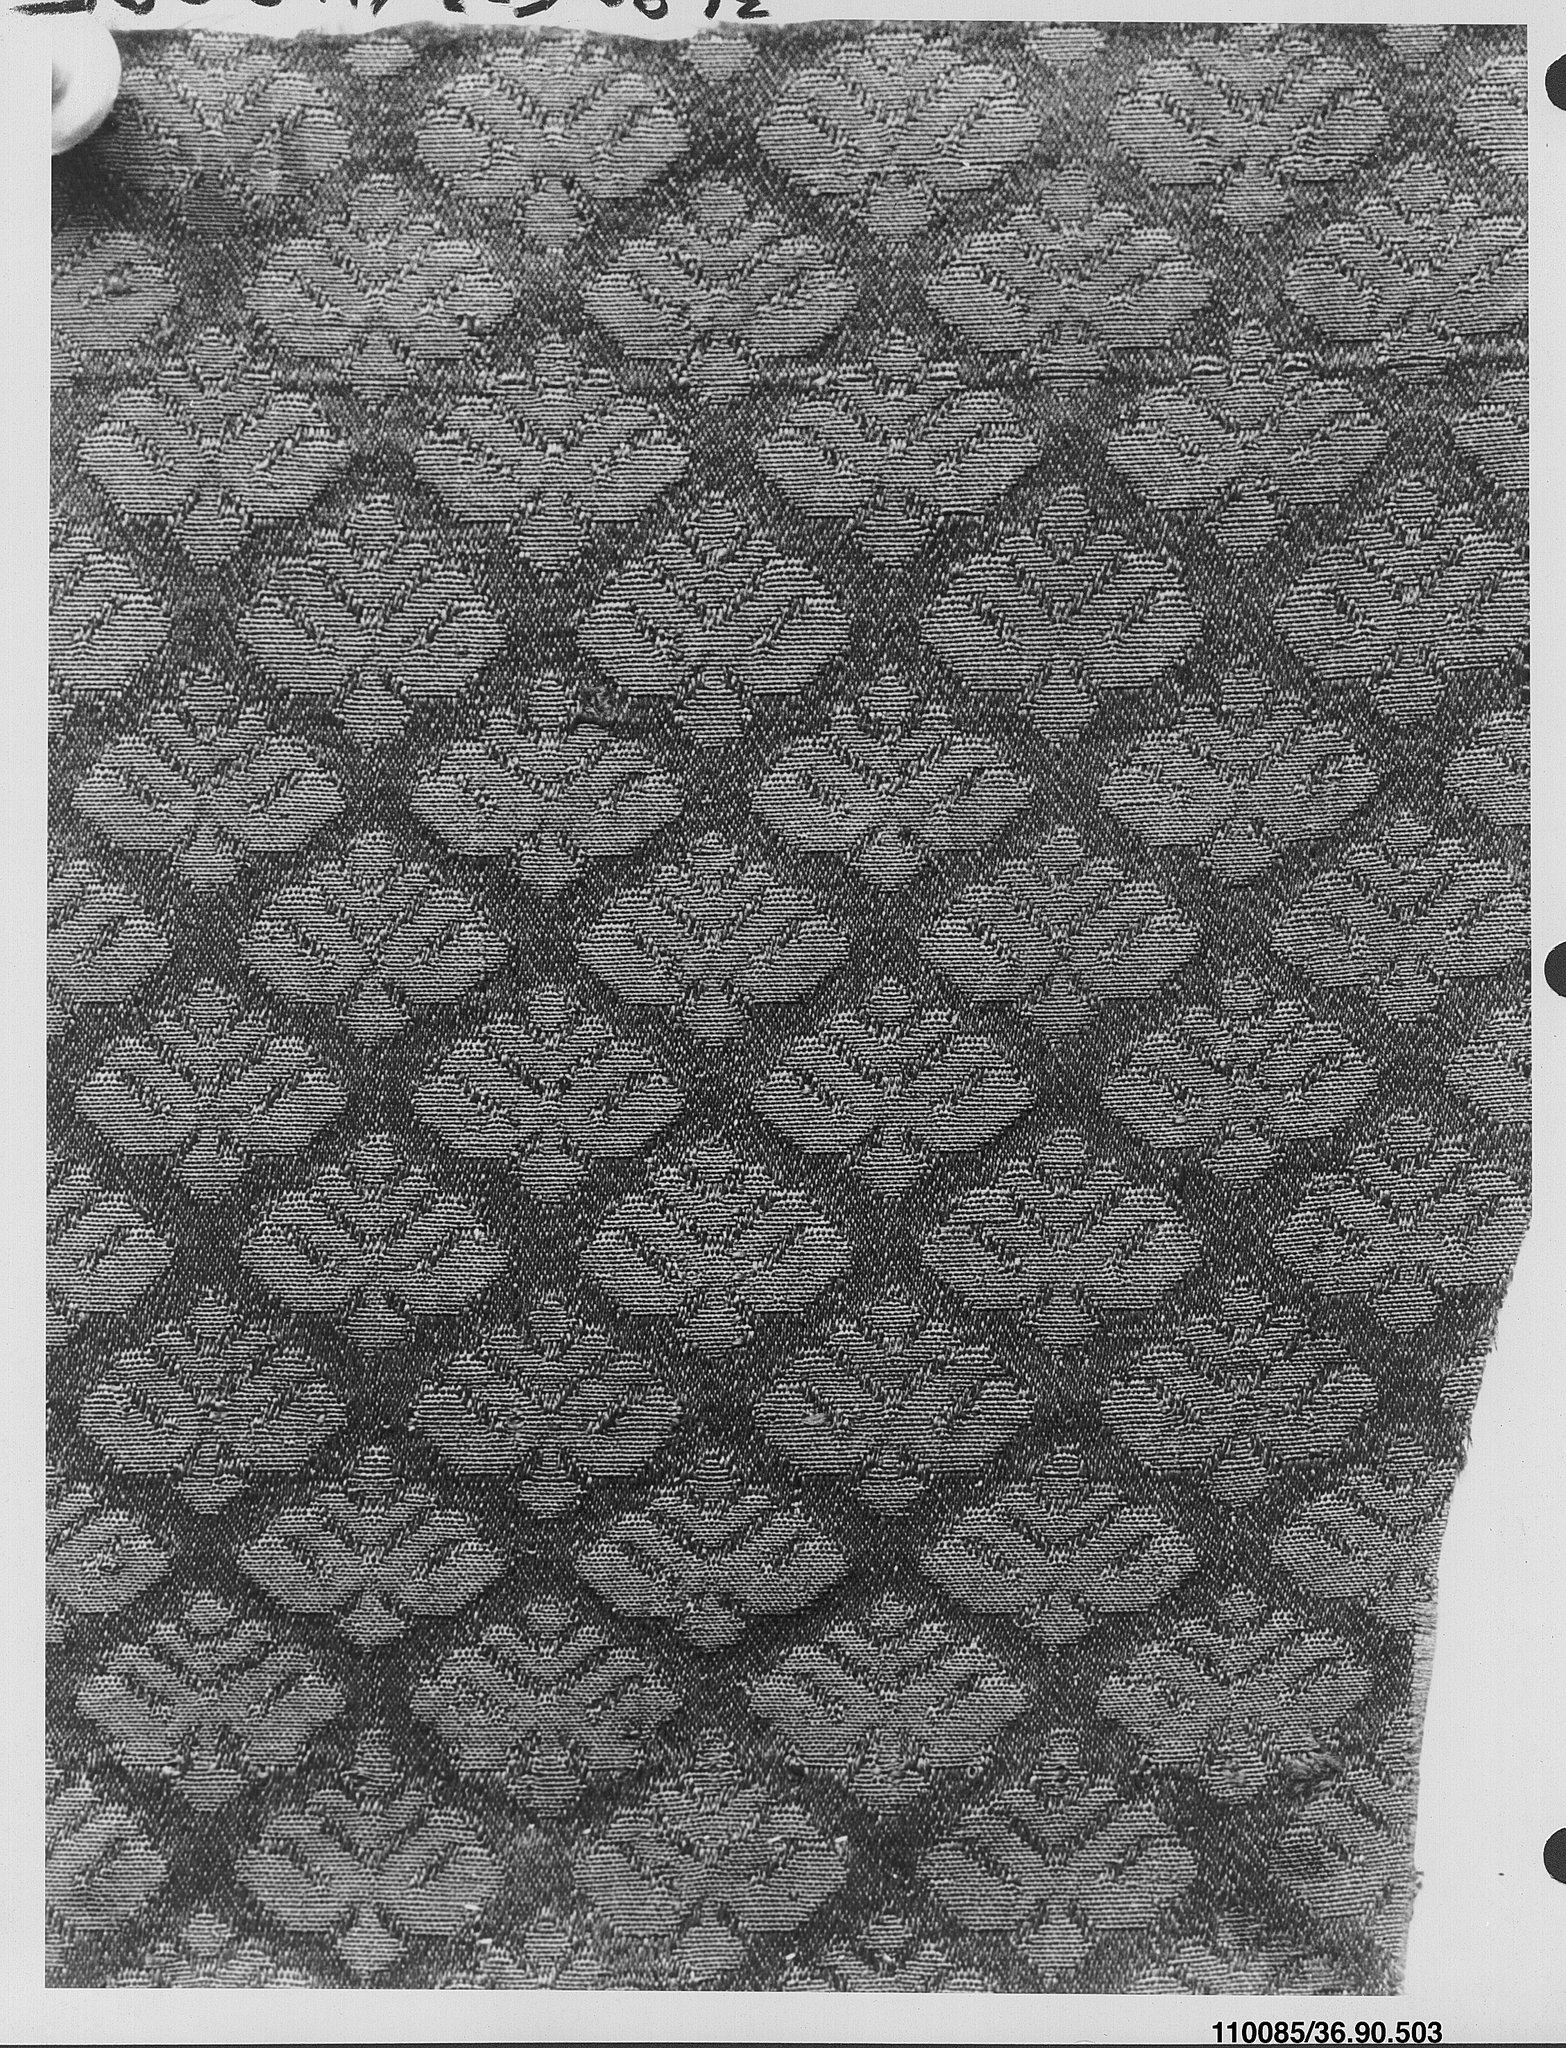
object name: piece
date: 1501-1700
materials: silk